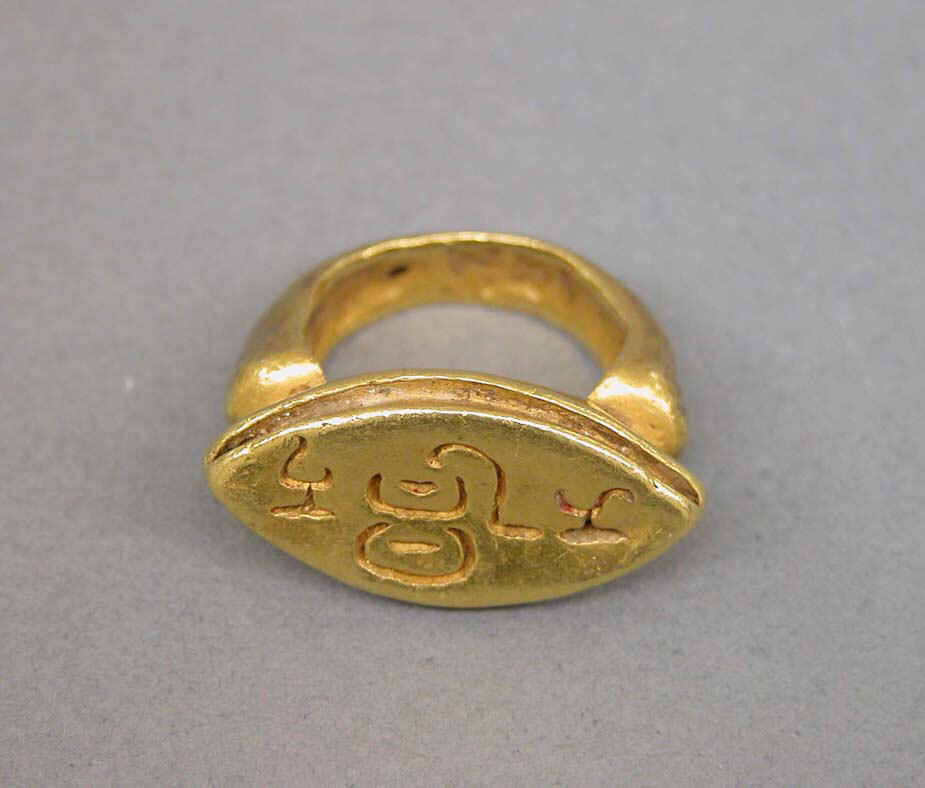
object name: ring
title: Stirrup-shaped Ring with Oblong Bezel with "Nagari"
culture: indonesian, javanese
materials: gold